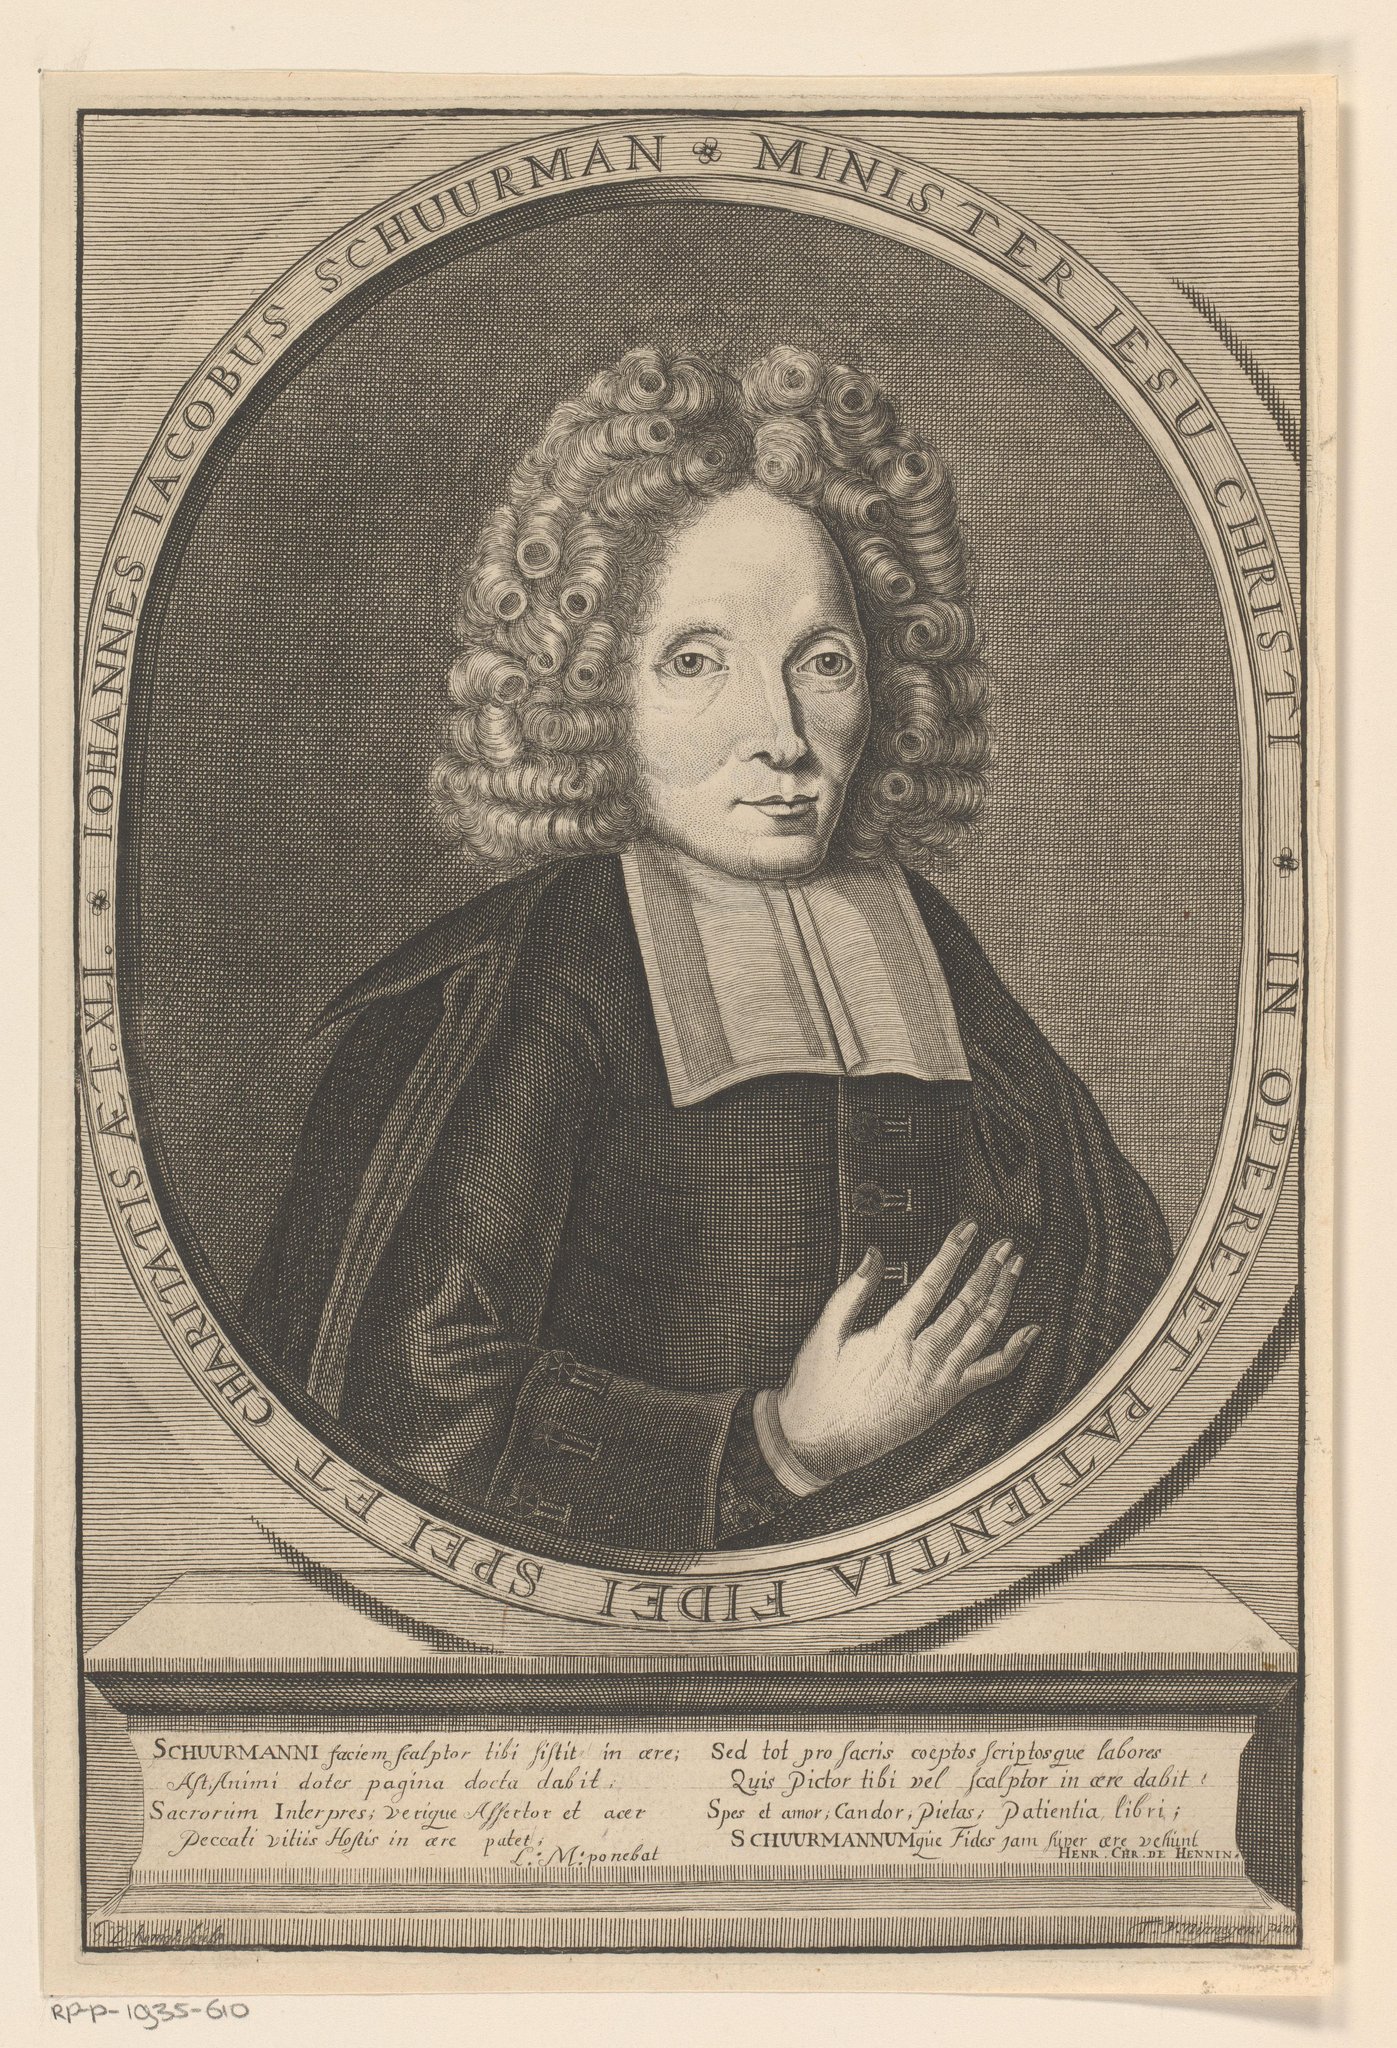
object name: print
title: Portret van Johannes Jacobus Schuurman op 41-jarige leeftijd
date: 1675-1724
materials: paper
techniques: engraving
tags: historical persons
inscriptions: collector's mark: Lugt 2760, collector's mark: Lugt 2228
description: Met achtregelig onderschrift in twee kolommen in het Latijn en tekst in het Latijn rondom het portret.